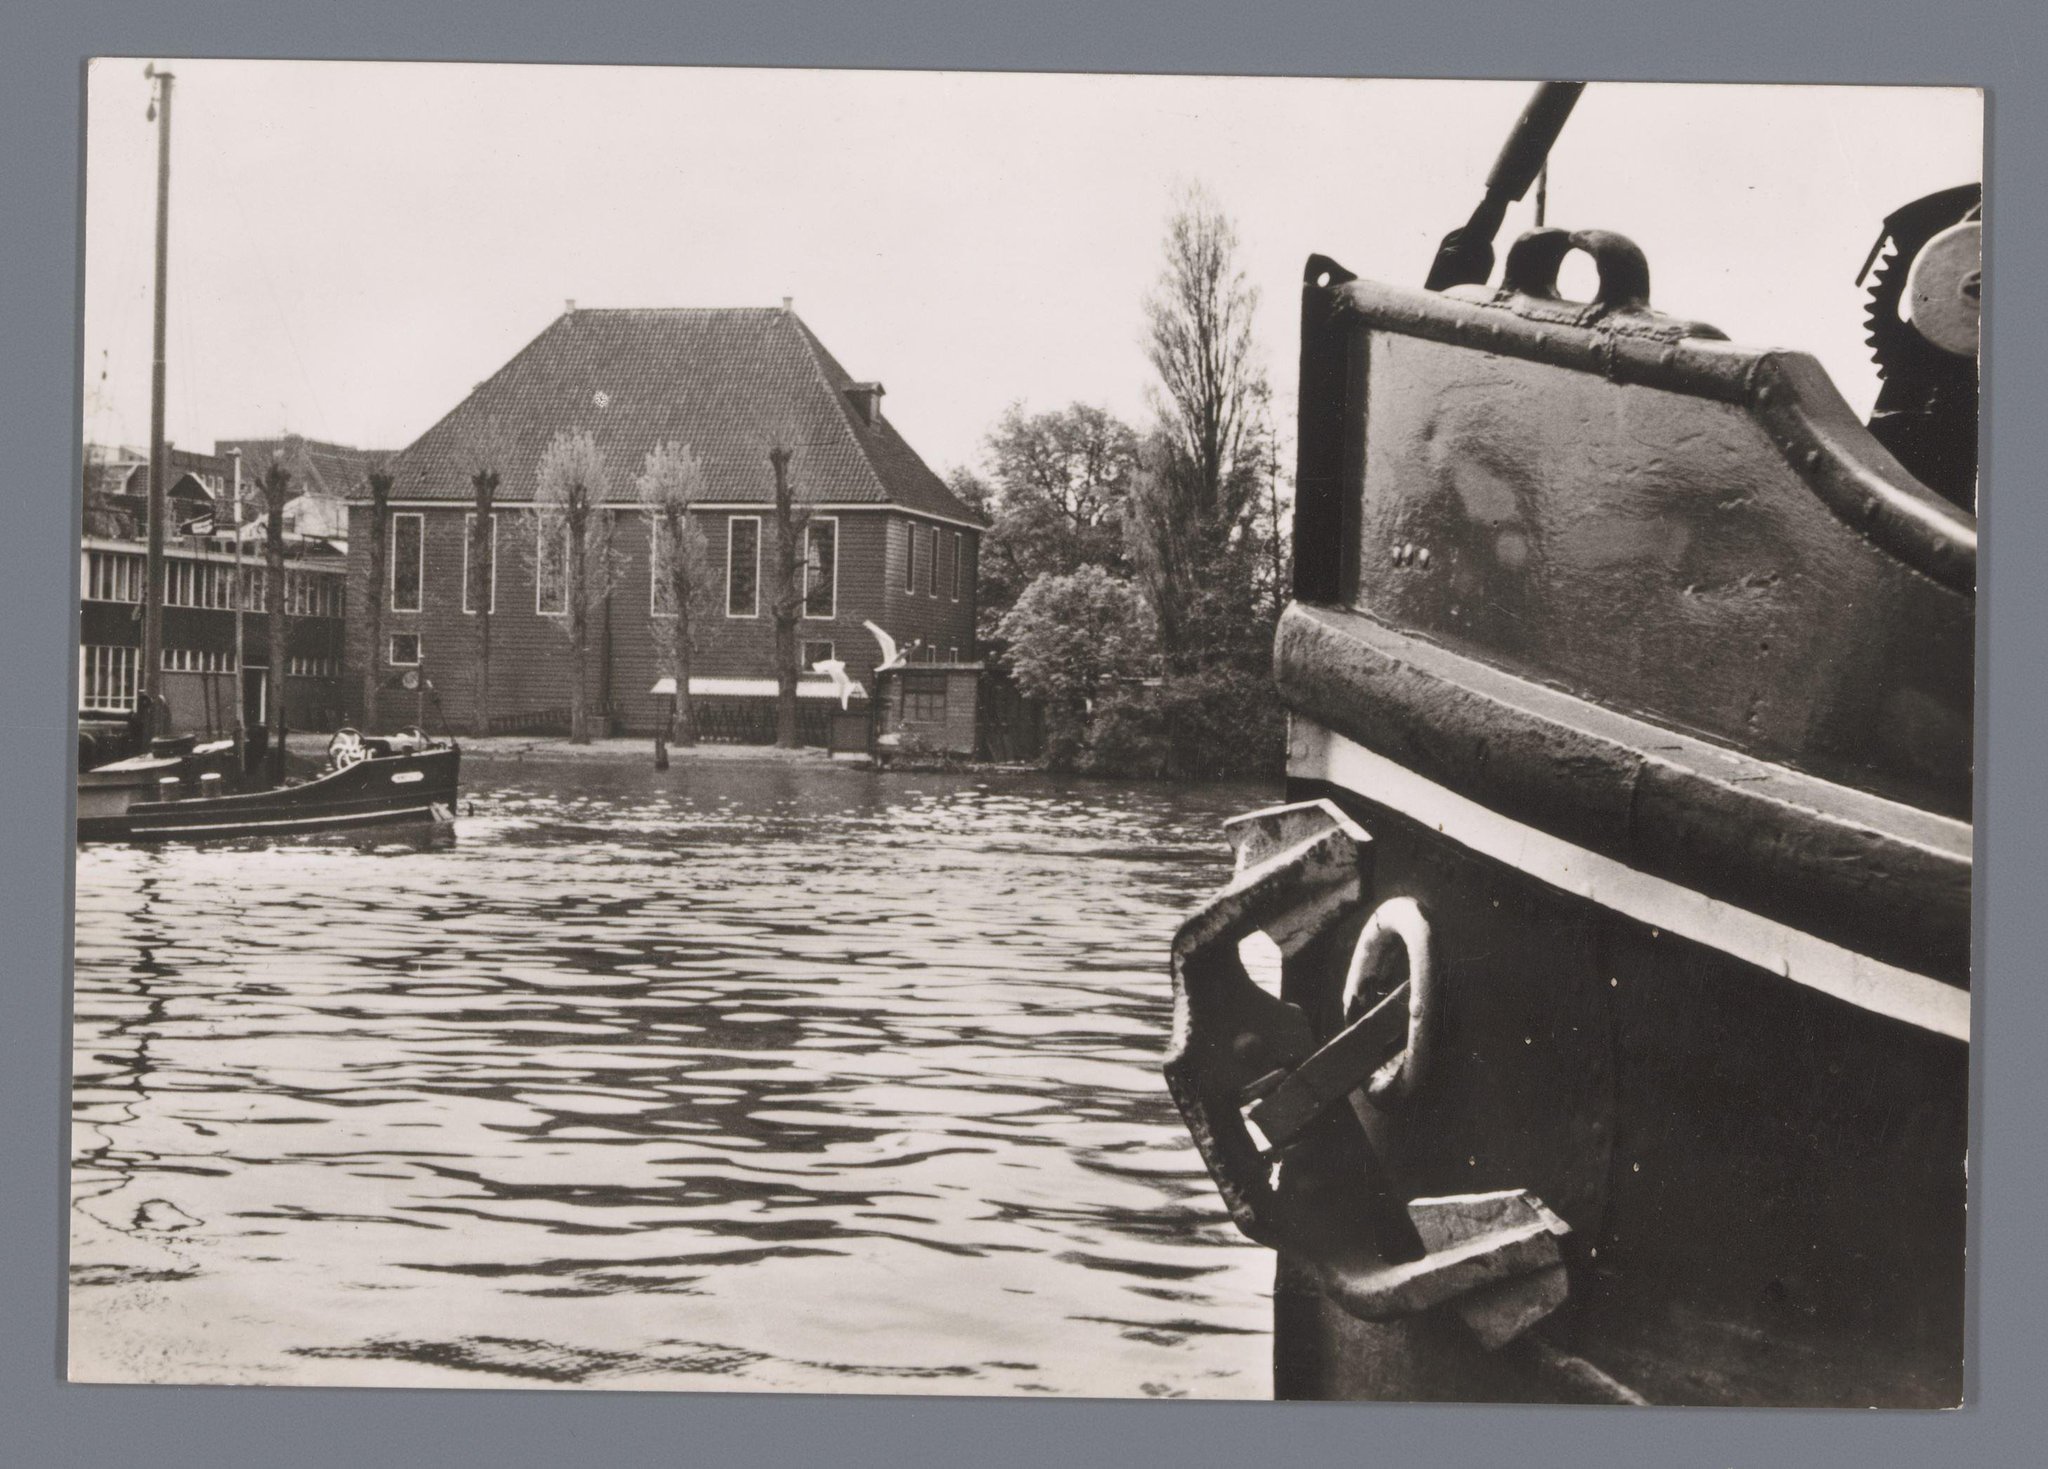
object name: photograph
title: Gezicht op de Doopsgezinde Vermaning te Zaandam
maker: cor van weele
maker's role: fotograaf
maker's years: 1918-1989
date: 1942-1973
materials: photographic support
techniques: gelatin silver print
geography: zaandam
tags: church (exterior)